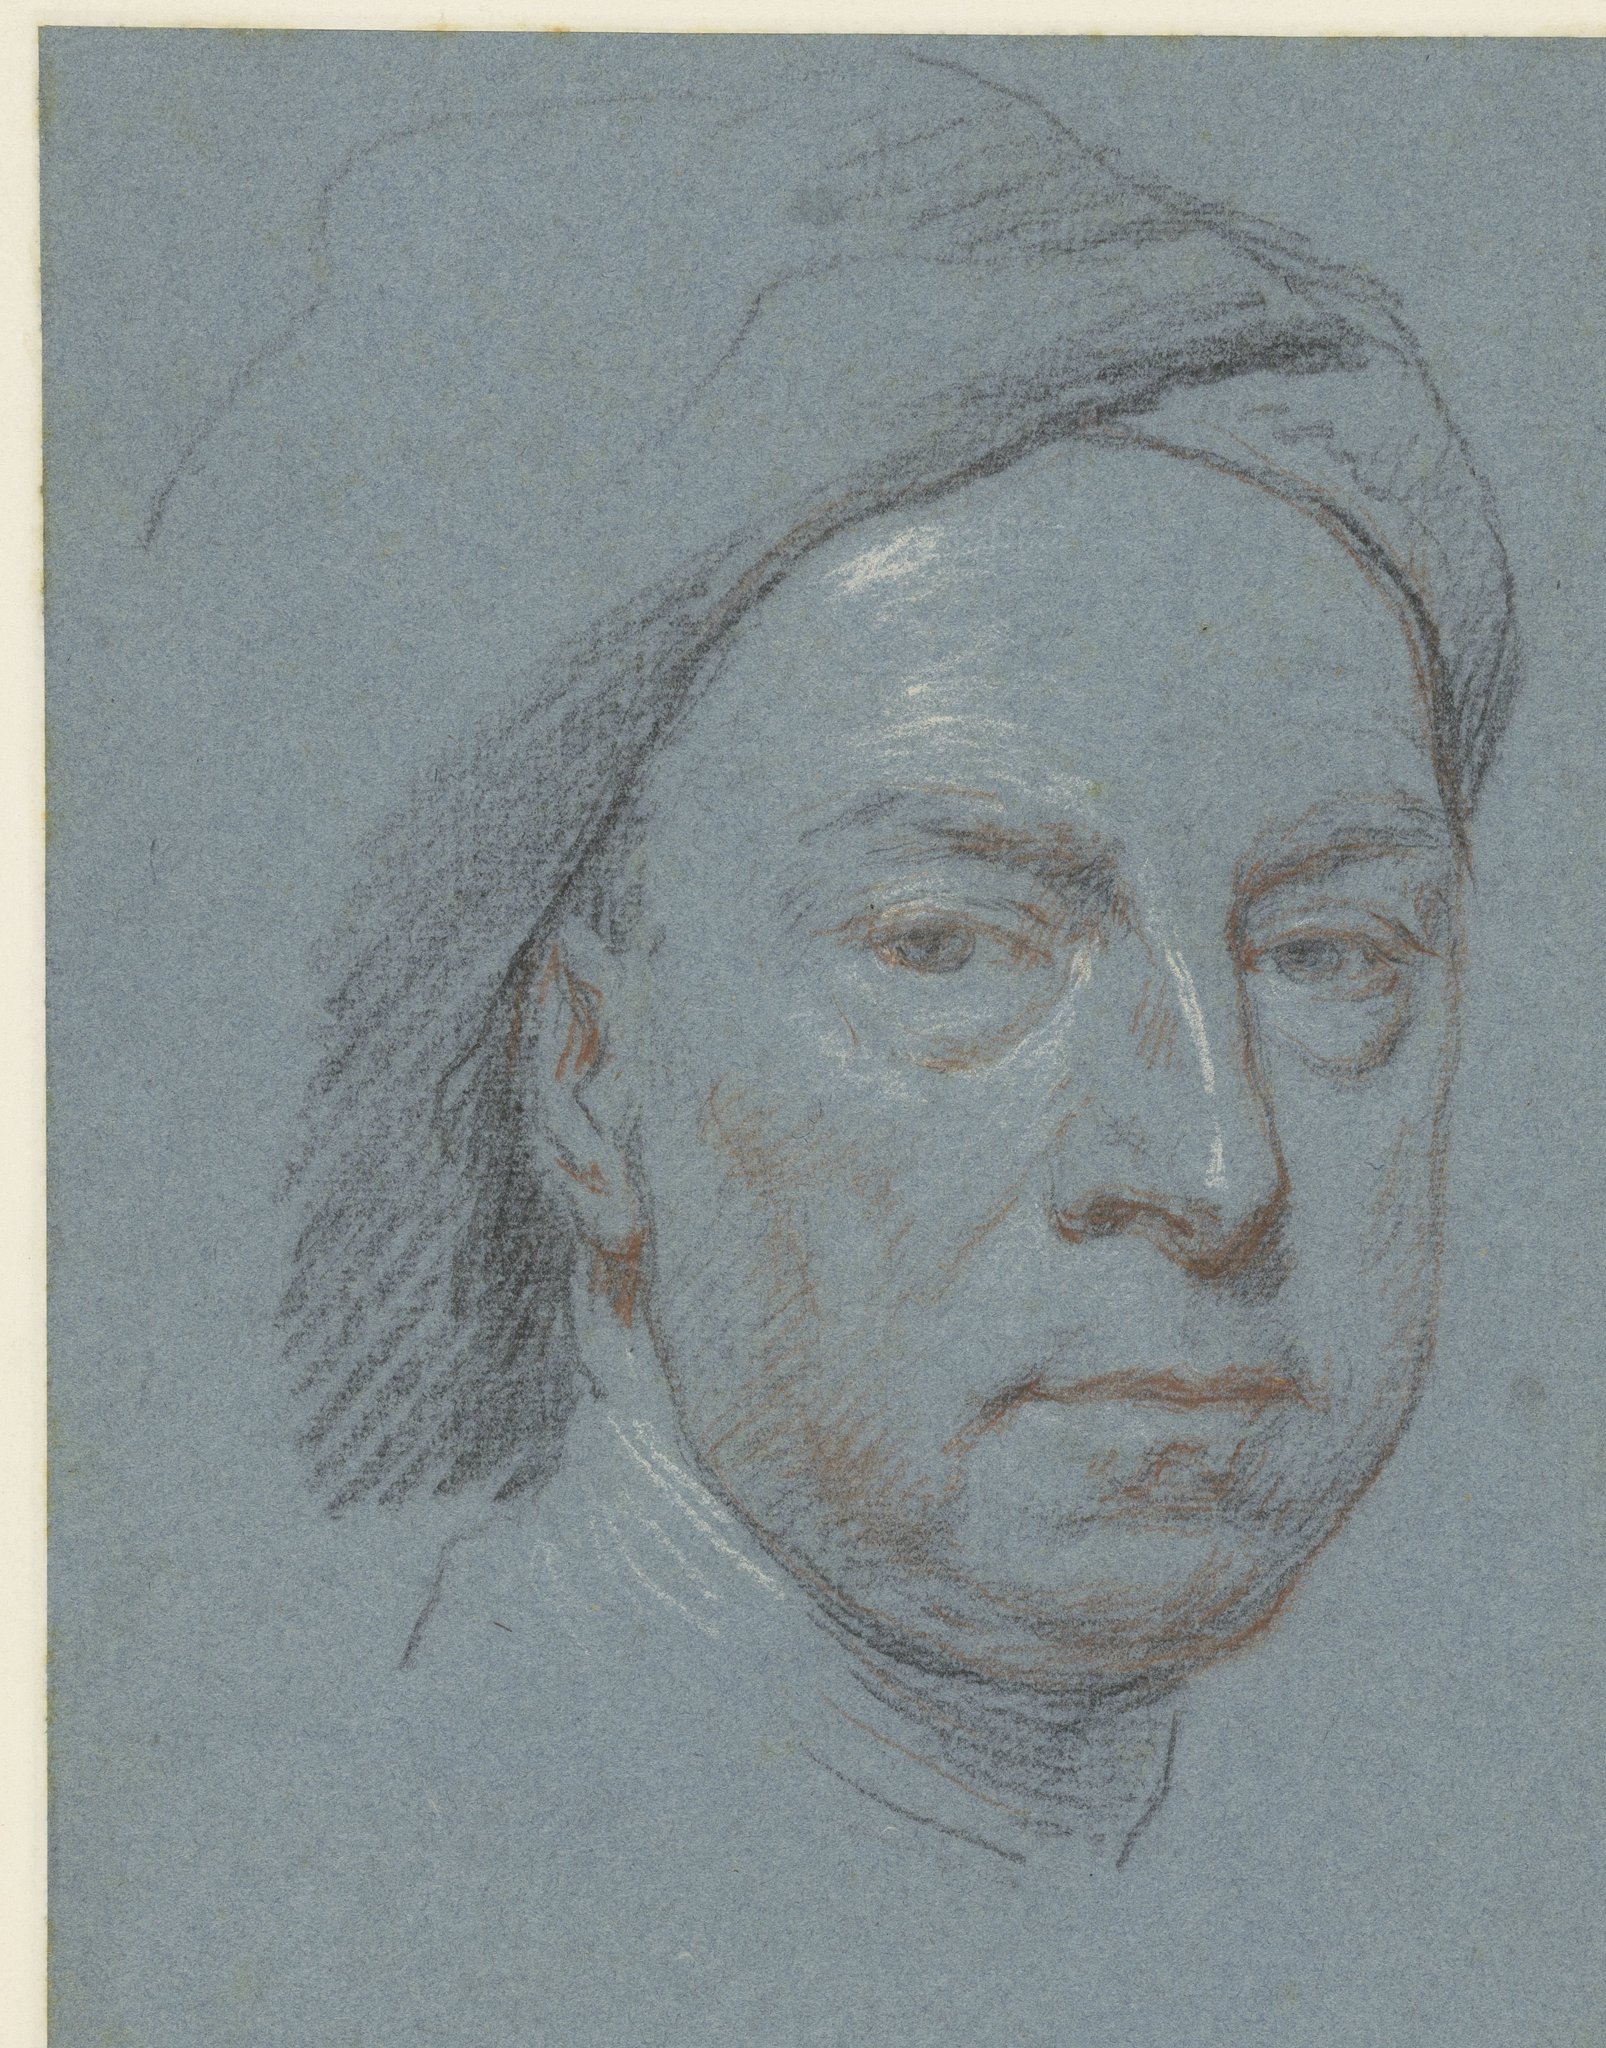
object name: drawing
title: Zelfportret van Jonathan Richardson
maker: jonathan richardson (i)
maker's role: draughtsman, print maker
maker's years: 1667-1745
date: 1700-1745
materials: chalk, paper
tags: london, print maker, draughtsman, jonathan richardson (i), historical persons, portrait, self-portrait of artist